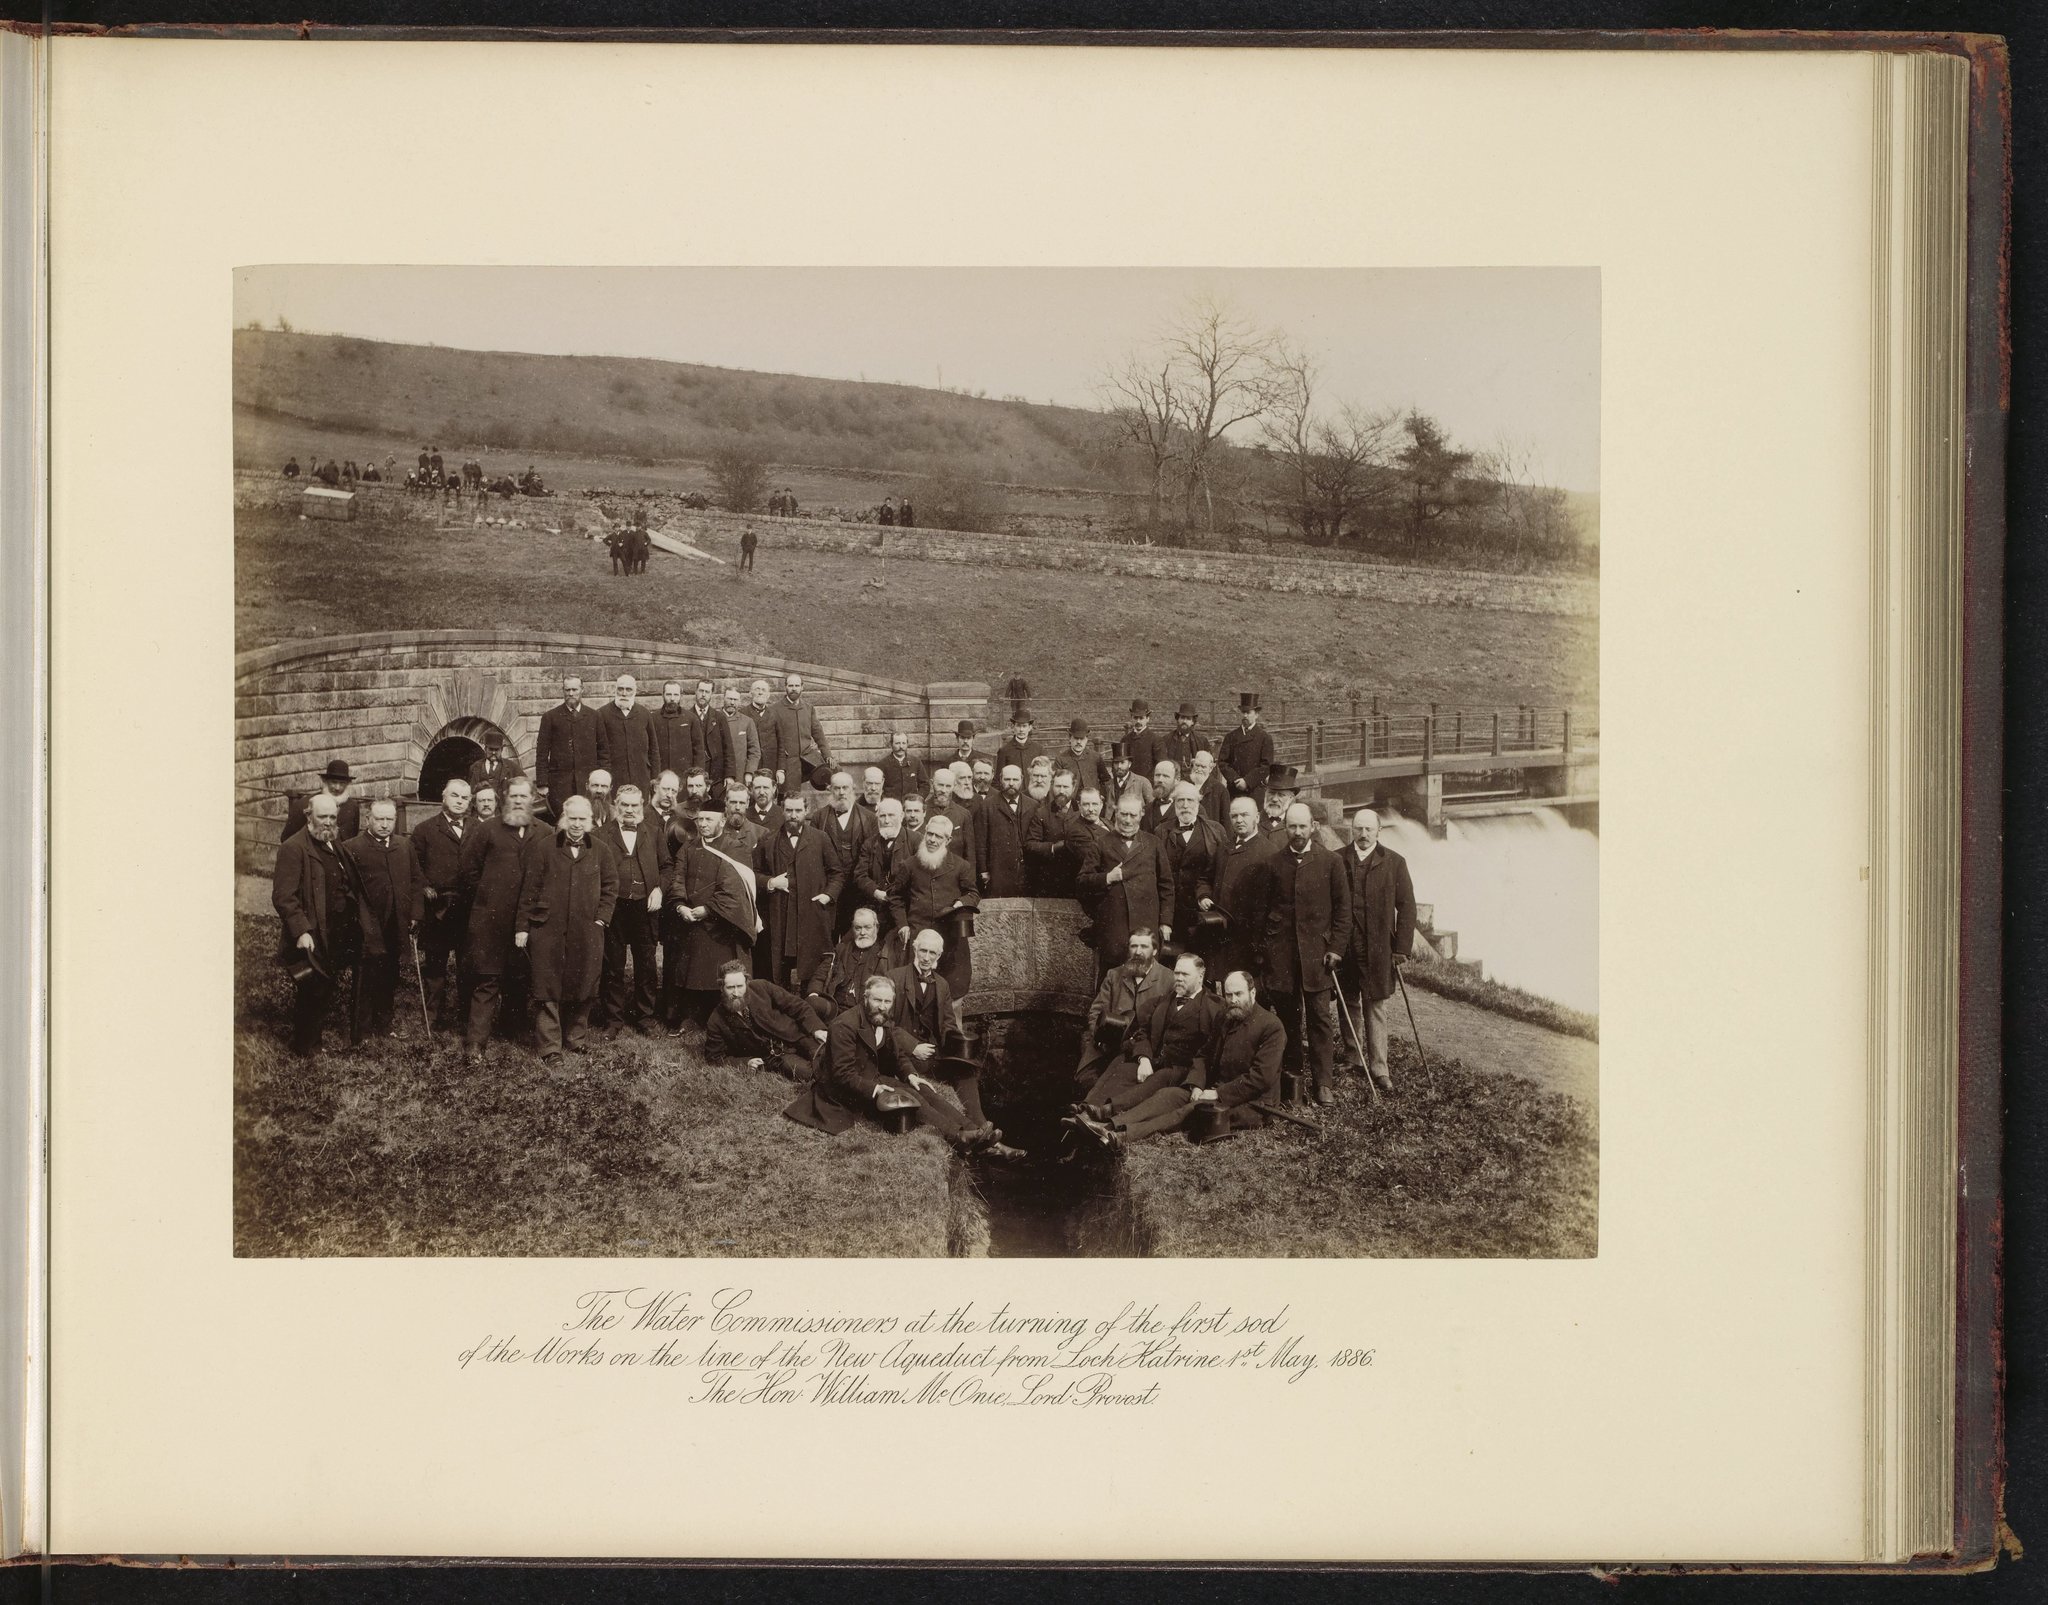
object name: page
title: The Water Commissioners at the turning of the first sod of the works on the line of the new aqueduct from Loch Katrine 1st May 1886. The Hon. William McOnie, Lord Provost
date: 1886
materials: photographic support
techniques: albumen print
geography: scottish highlands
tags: committee members, board members, anonymous historical persons portrayed in a group, in a group-portrait